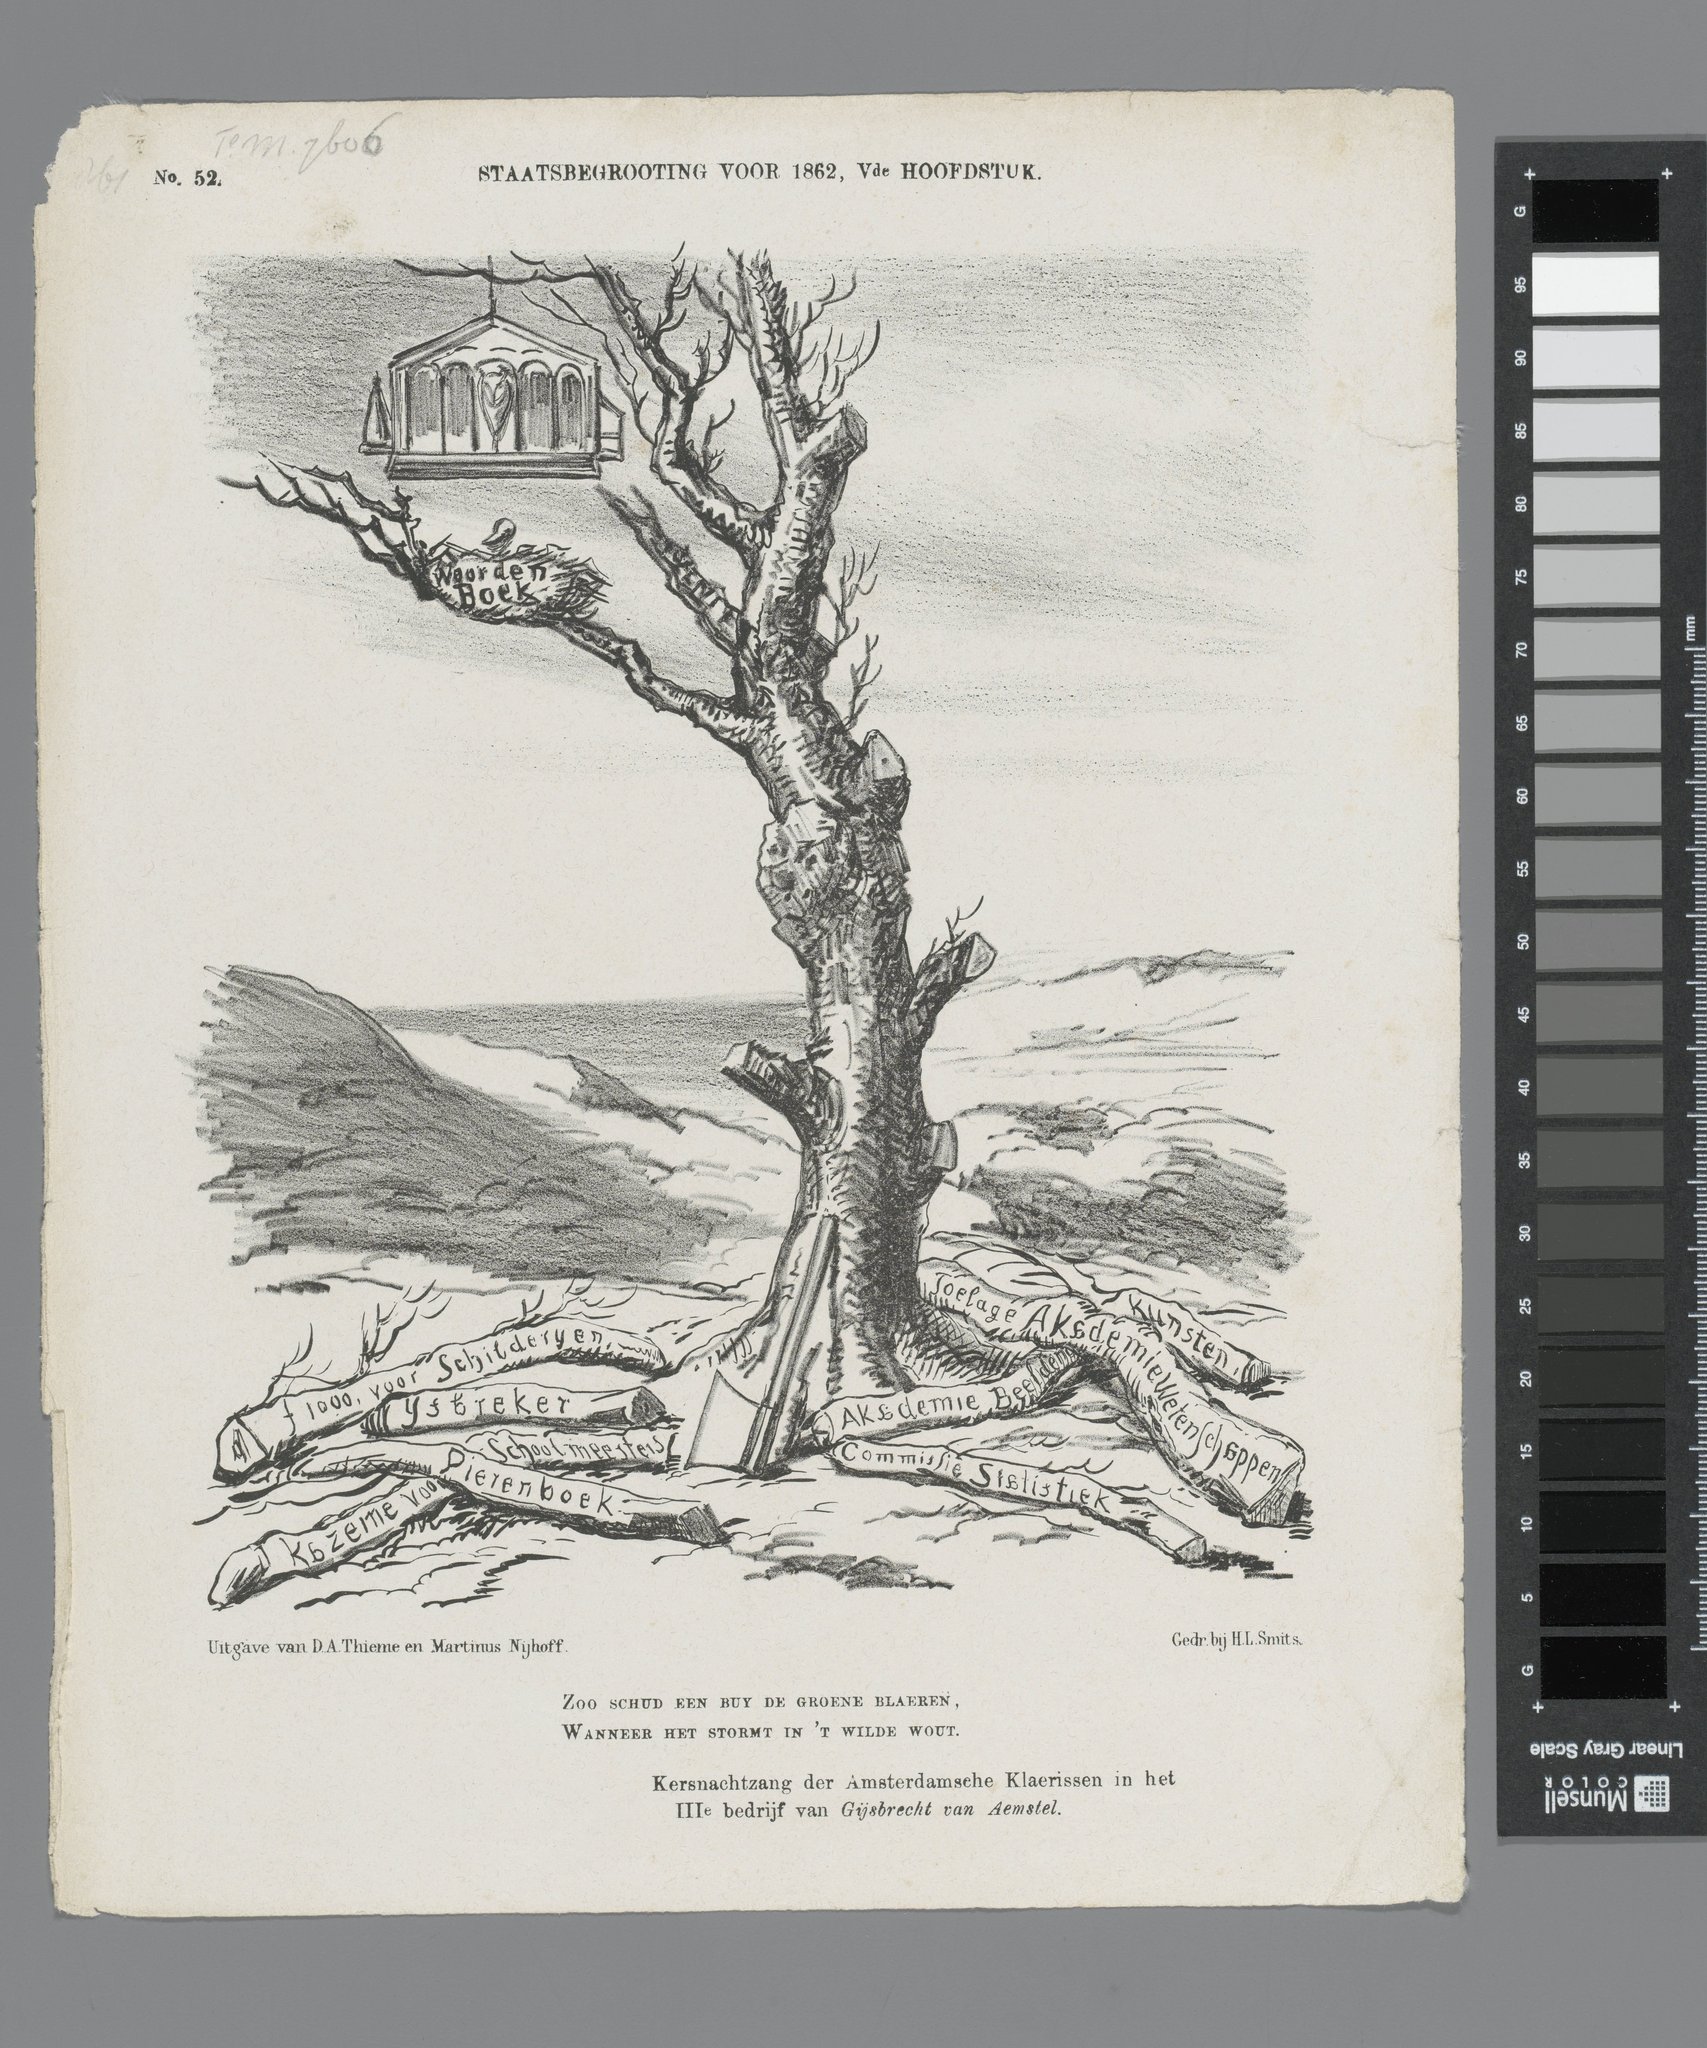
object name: cartoon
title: Spotprent op de staatsbegroting voor het komende jaar, 1861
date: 1861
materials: paper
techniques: lithograph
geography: netherlands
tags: woodcutting, woodcutter ~ forestry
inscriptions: collector's mark: Lugt 2228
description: Spotprent op alle plannen die gesneuveld zijn in de staatsbegroting voor het komende jaar 1862. Een kale boom waarvan bijna alle takken afgehakt op de grond liggen, alleen de tak 'Woordenboek' zit nog aan de boom. Plaat verschenen bij het weekblad De Nederlandsche Spectator, nr. 52, 28 december 1861.